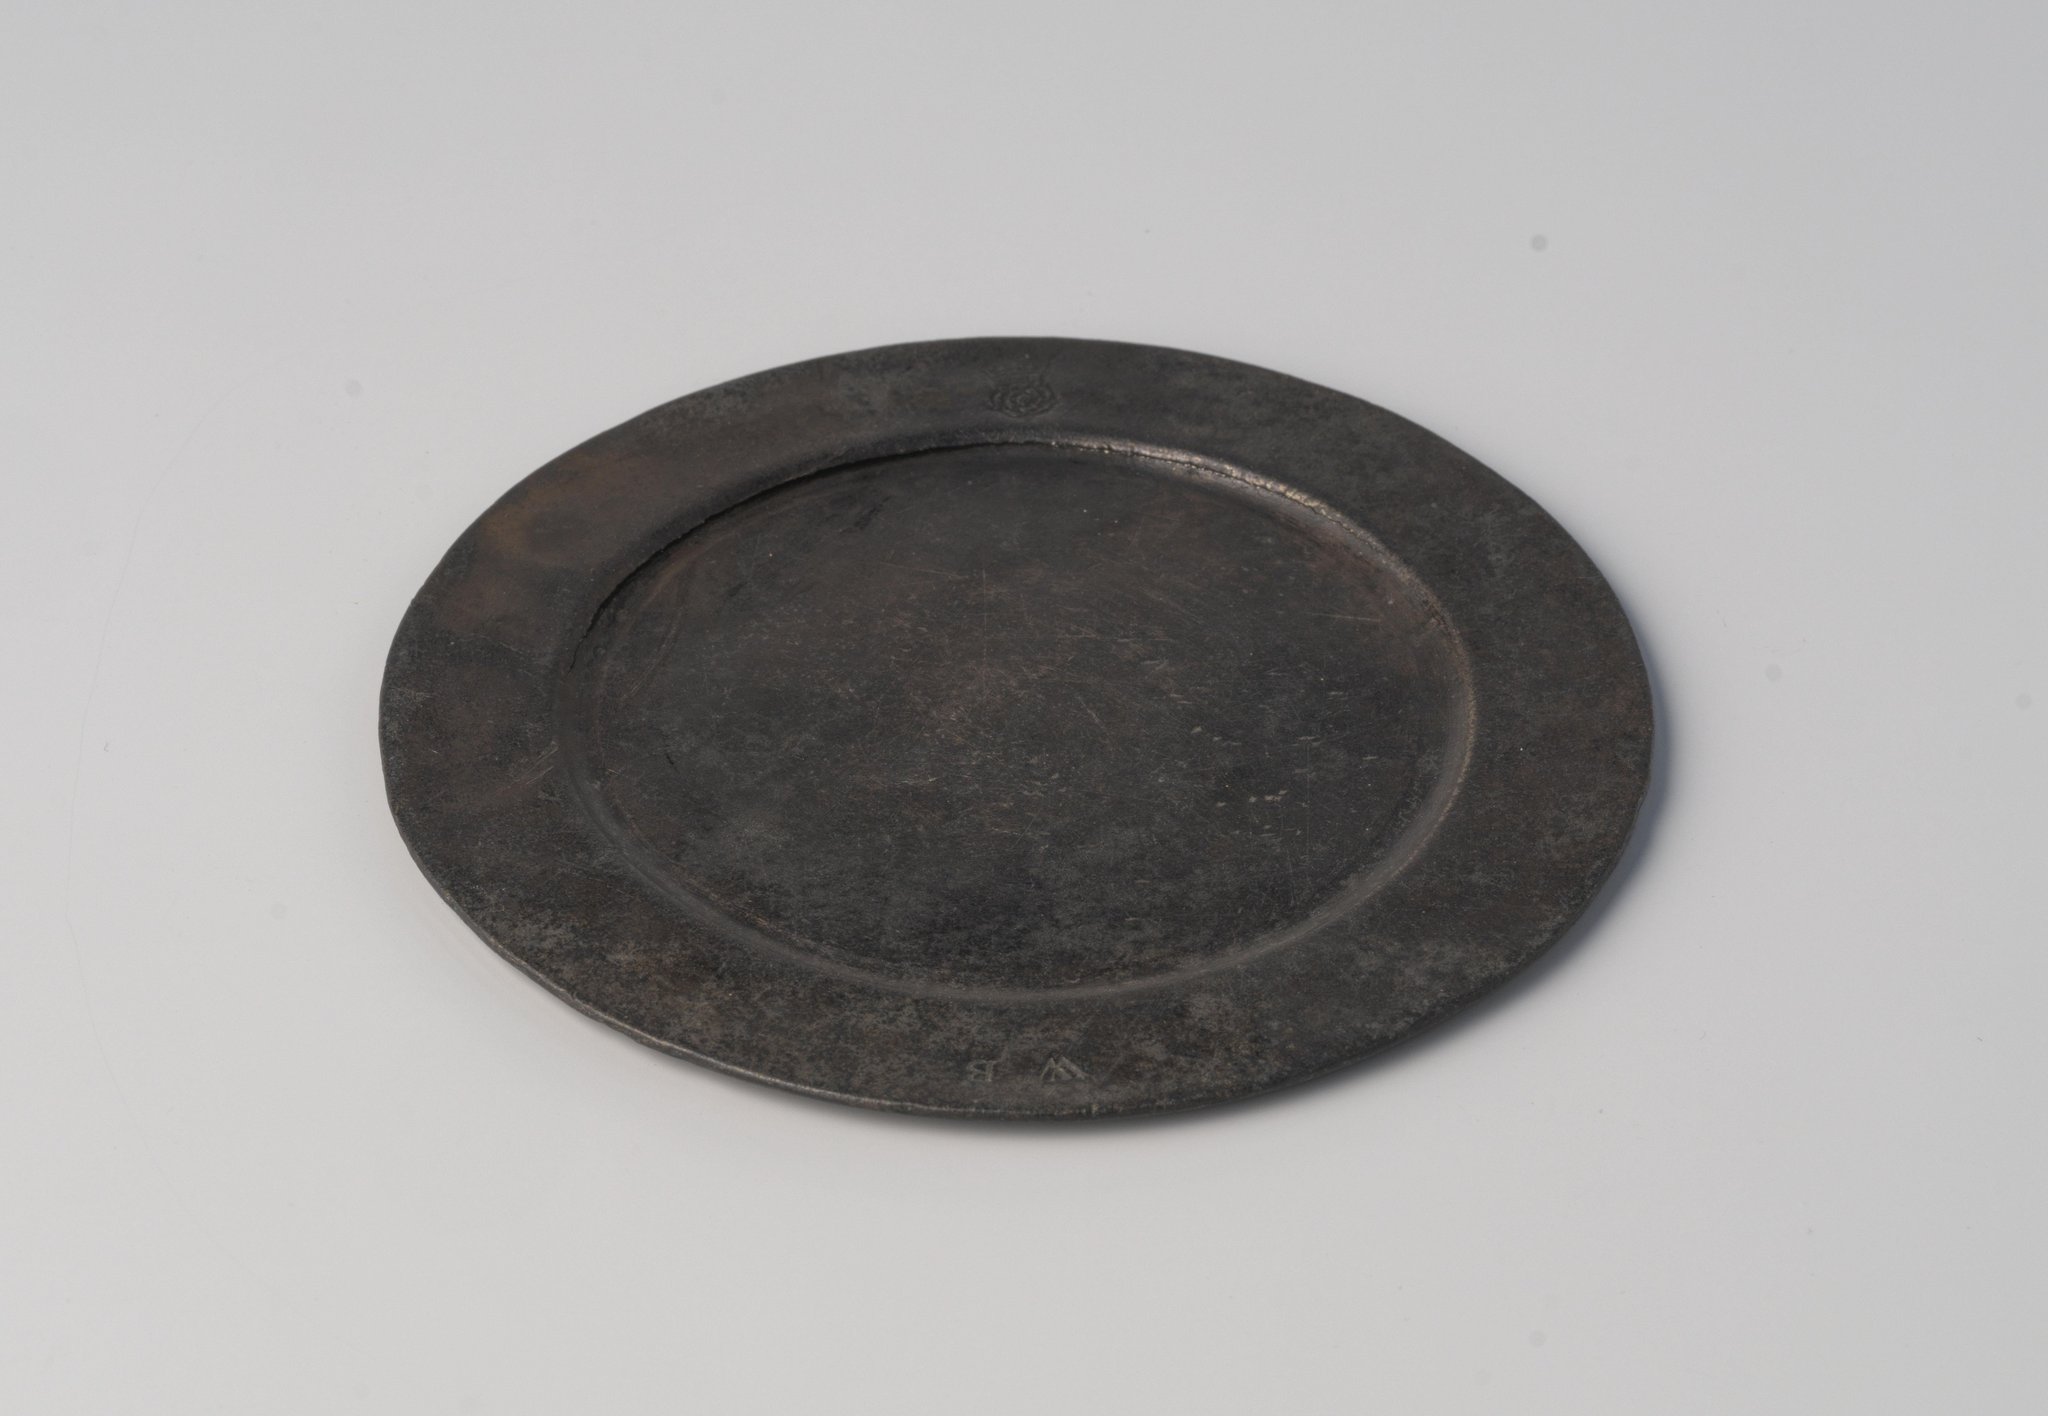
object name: plate dish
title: Bord van tin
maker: Anonymous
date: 1550-1600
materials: tin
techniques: casting, turning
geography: netherlands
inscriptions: initials: ‘WB’, quality mark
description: Bord van tin met een zeer ondiep plat. De rand is naar onder omgebogen.